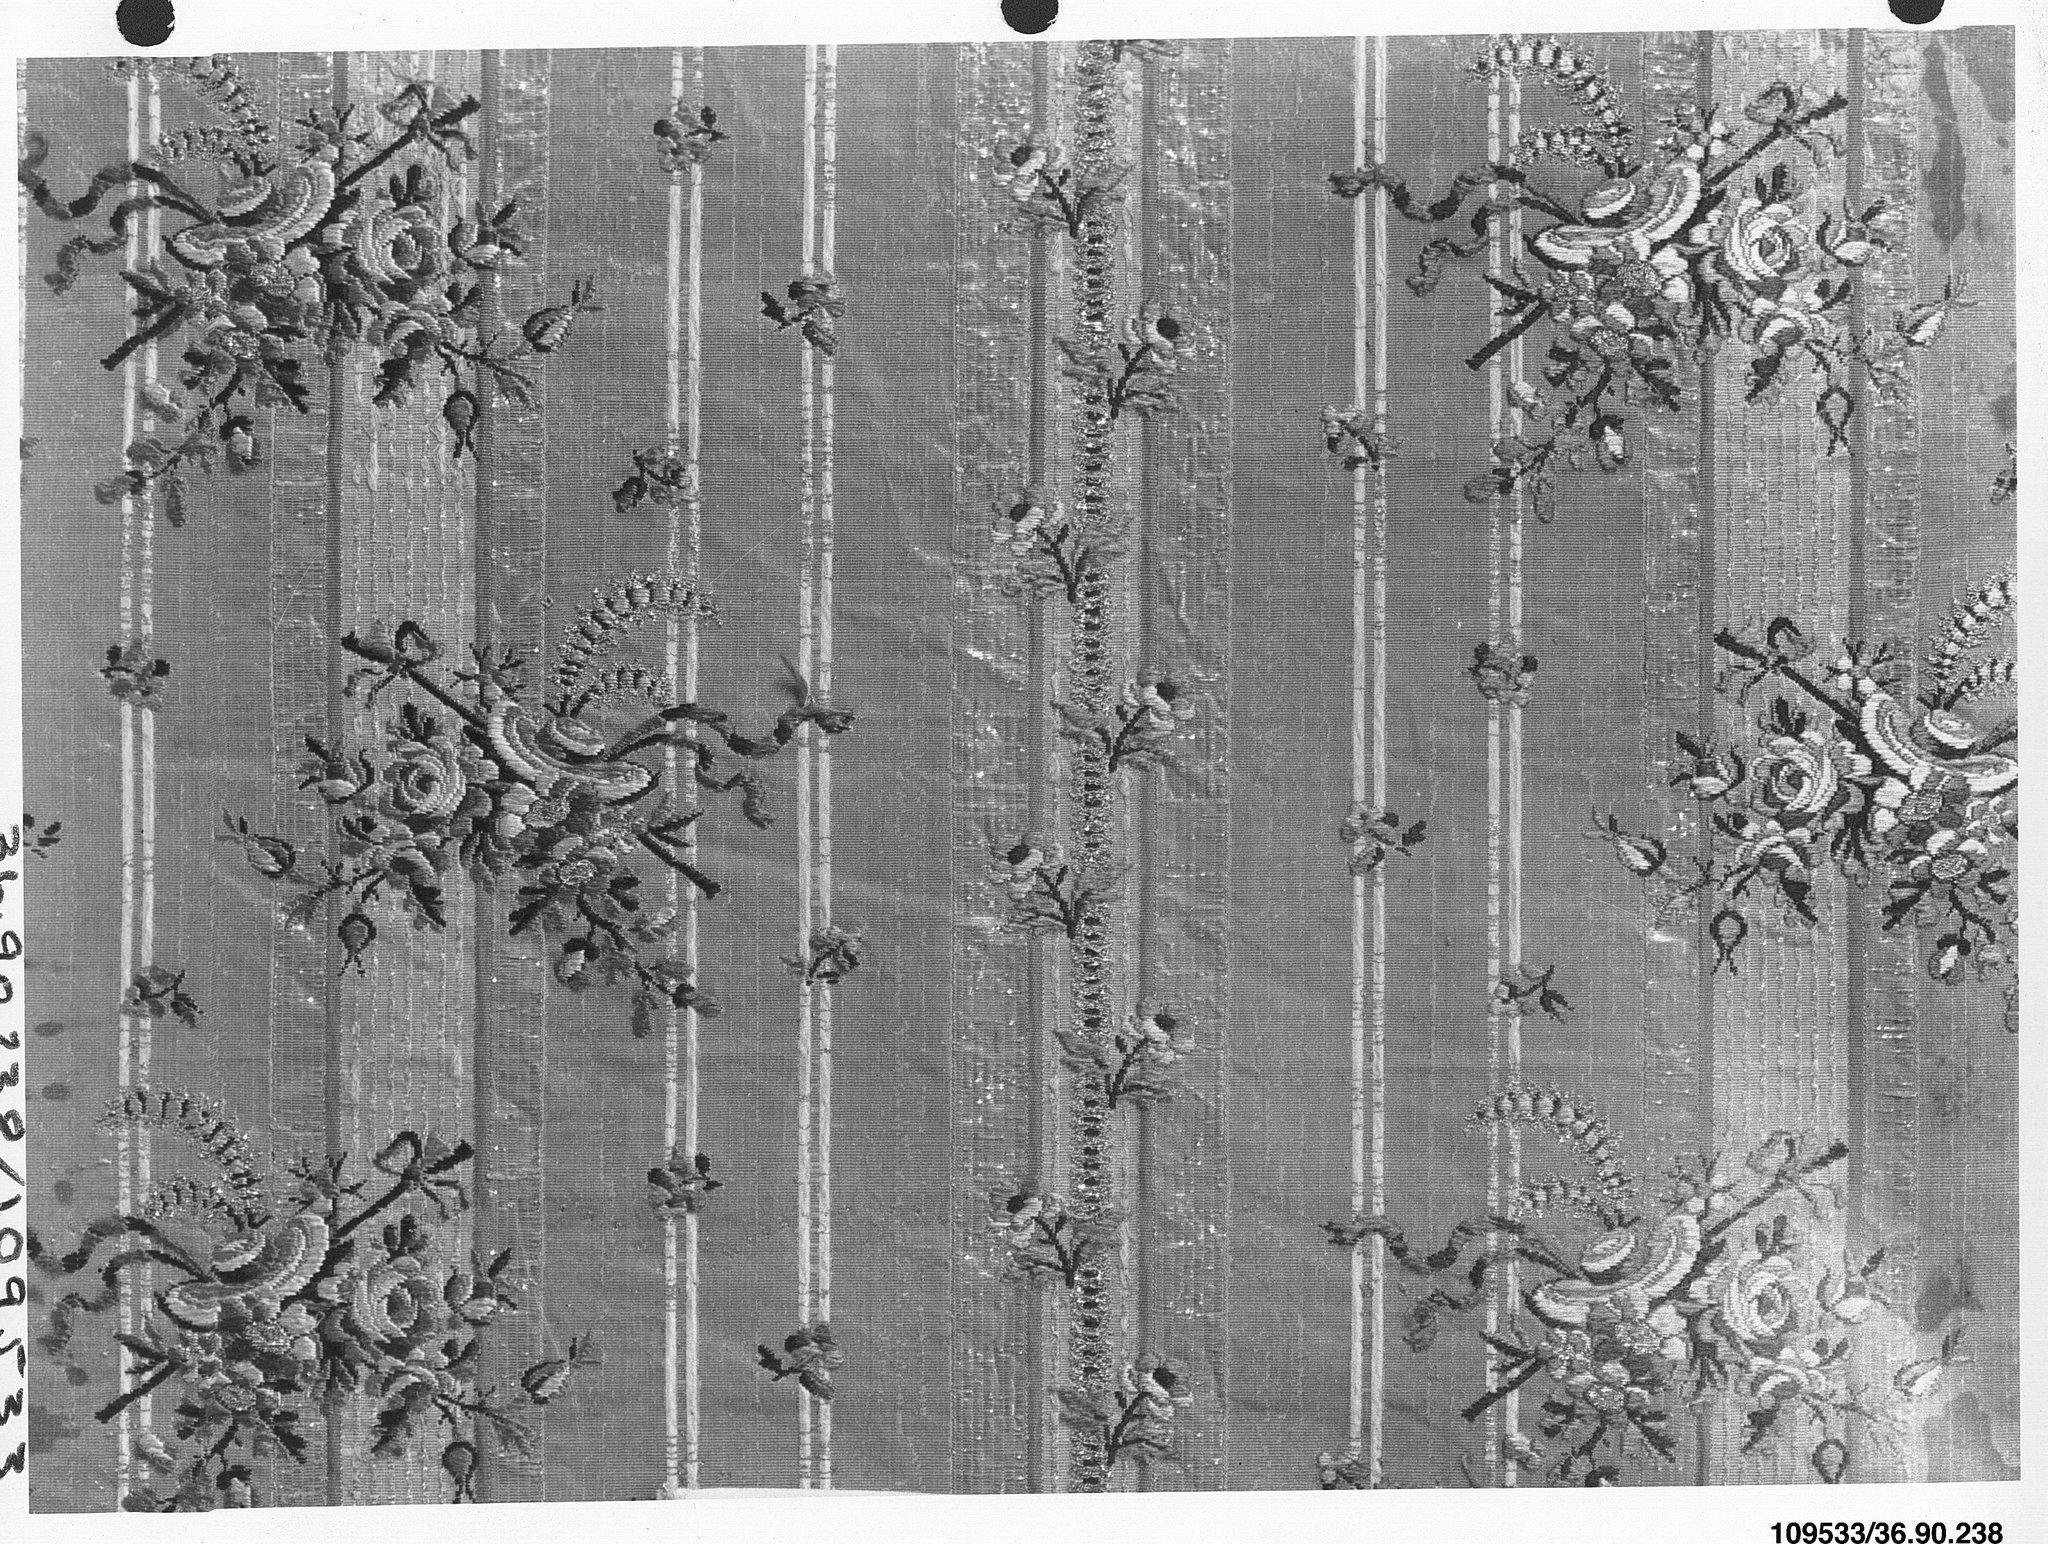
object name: piece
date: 1701-1800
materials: metal thread, silk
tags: flowers,leaves